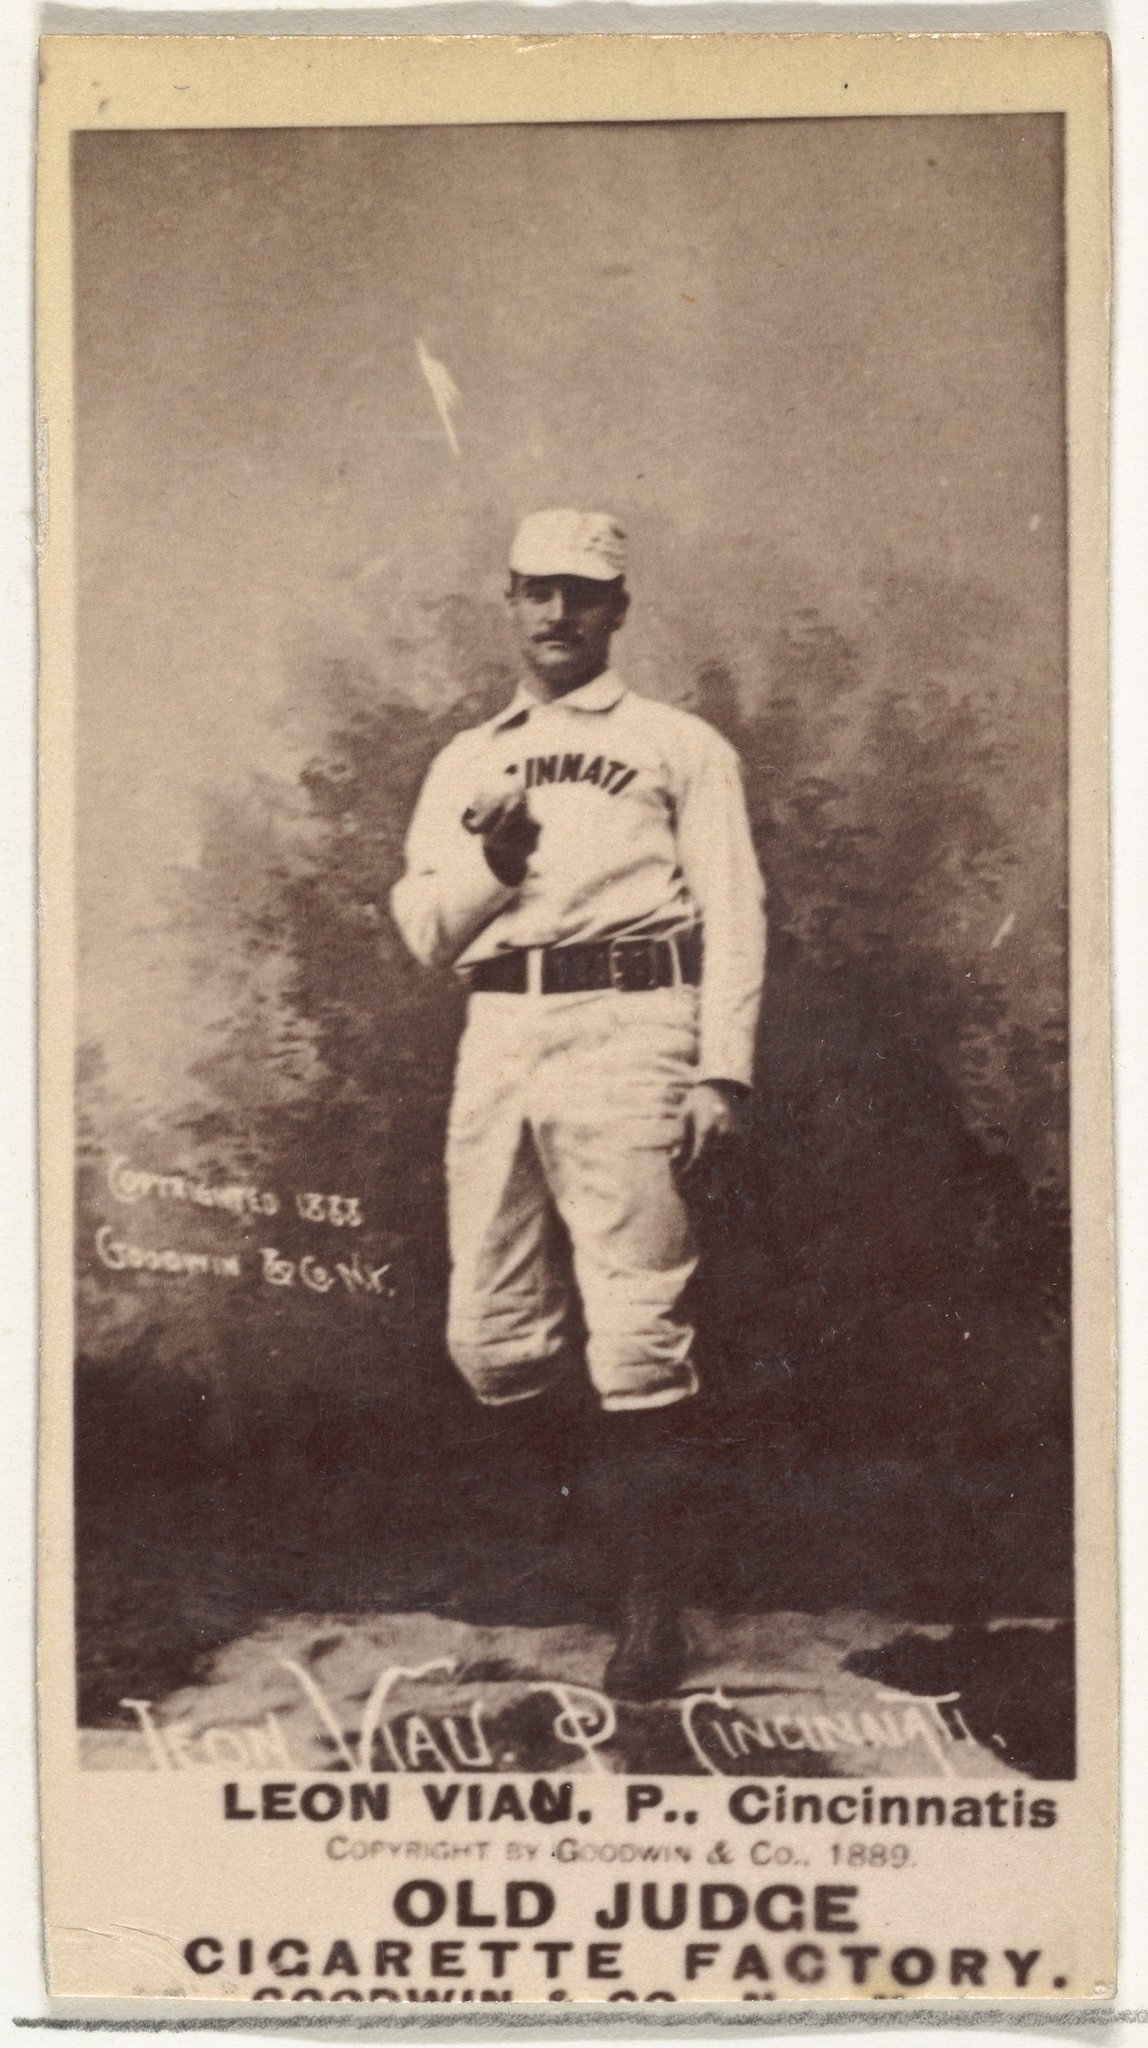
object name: baseball card, photograph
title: Leon A. "Lee" Viau, Pitcher, Cincinnati, from the Old Judge series (N172) for Old Judge Cigarettes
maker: goodwin & company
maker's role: publisher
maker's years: 1850-1950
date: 1889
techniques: albumen silver print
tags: men,portraits,baseball,athletes